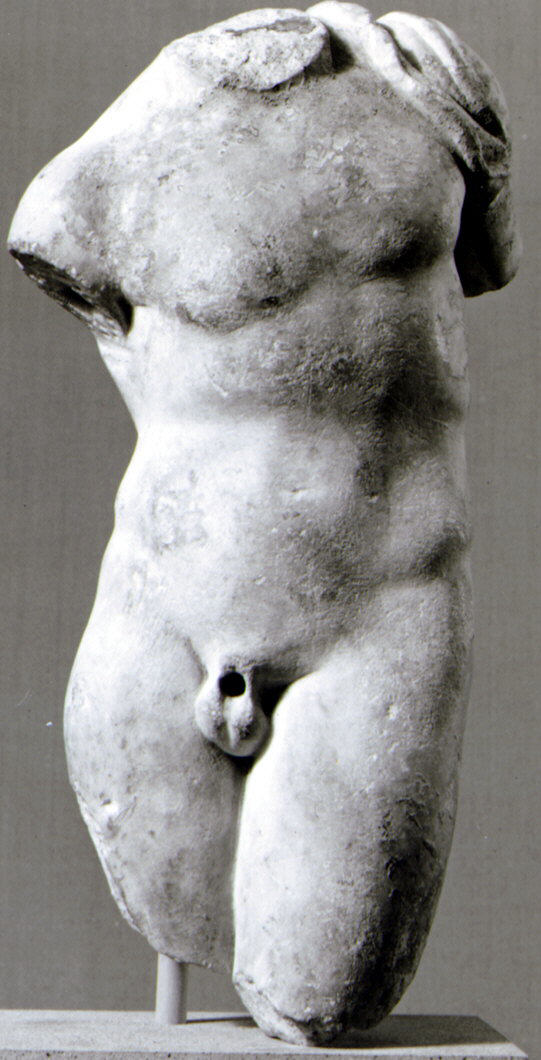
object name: torso of a boy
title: Marble statue of a boy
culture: roman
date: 1-100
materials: marble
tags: male nudes